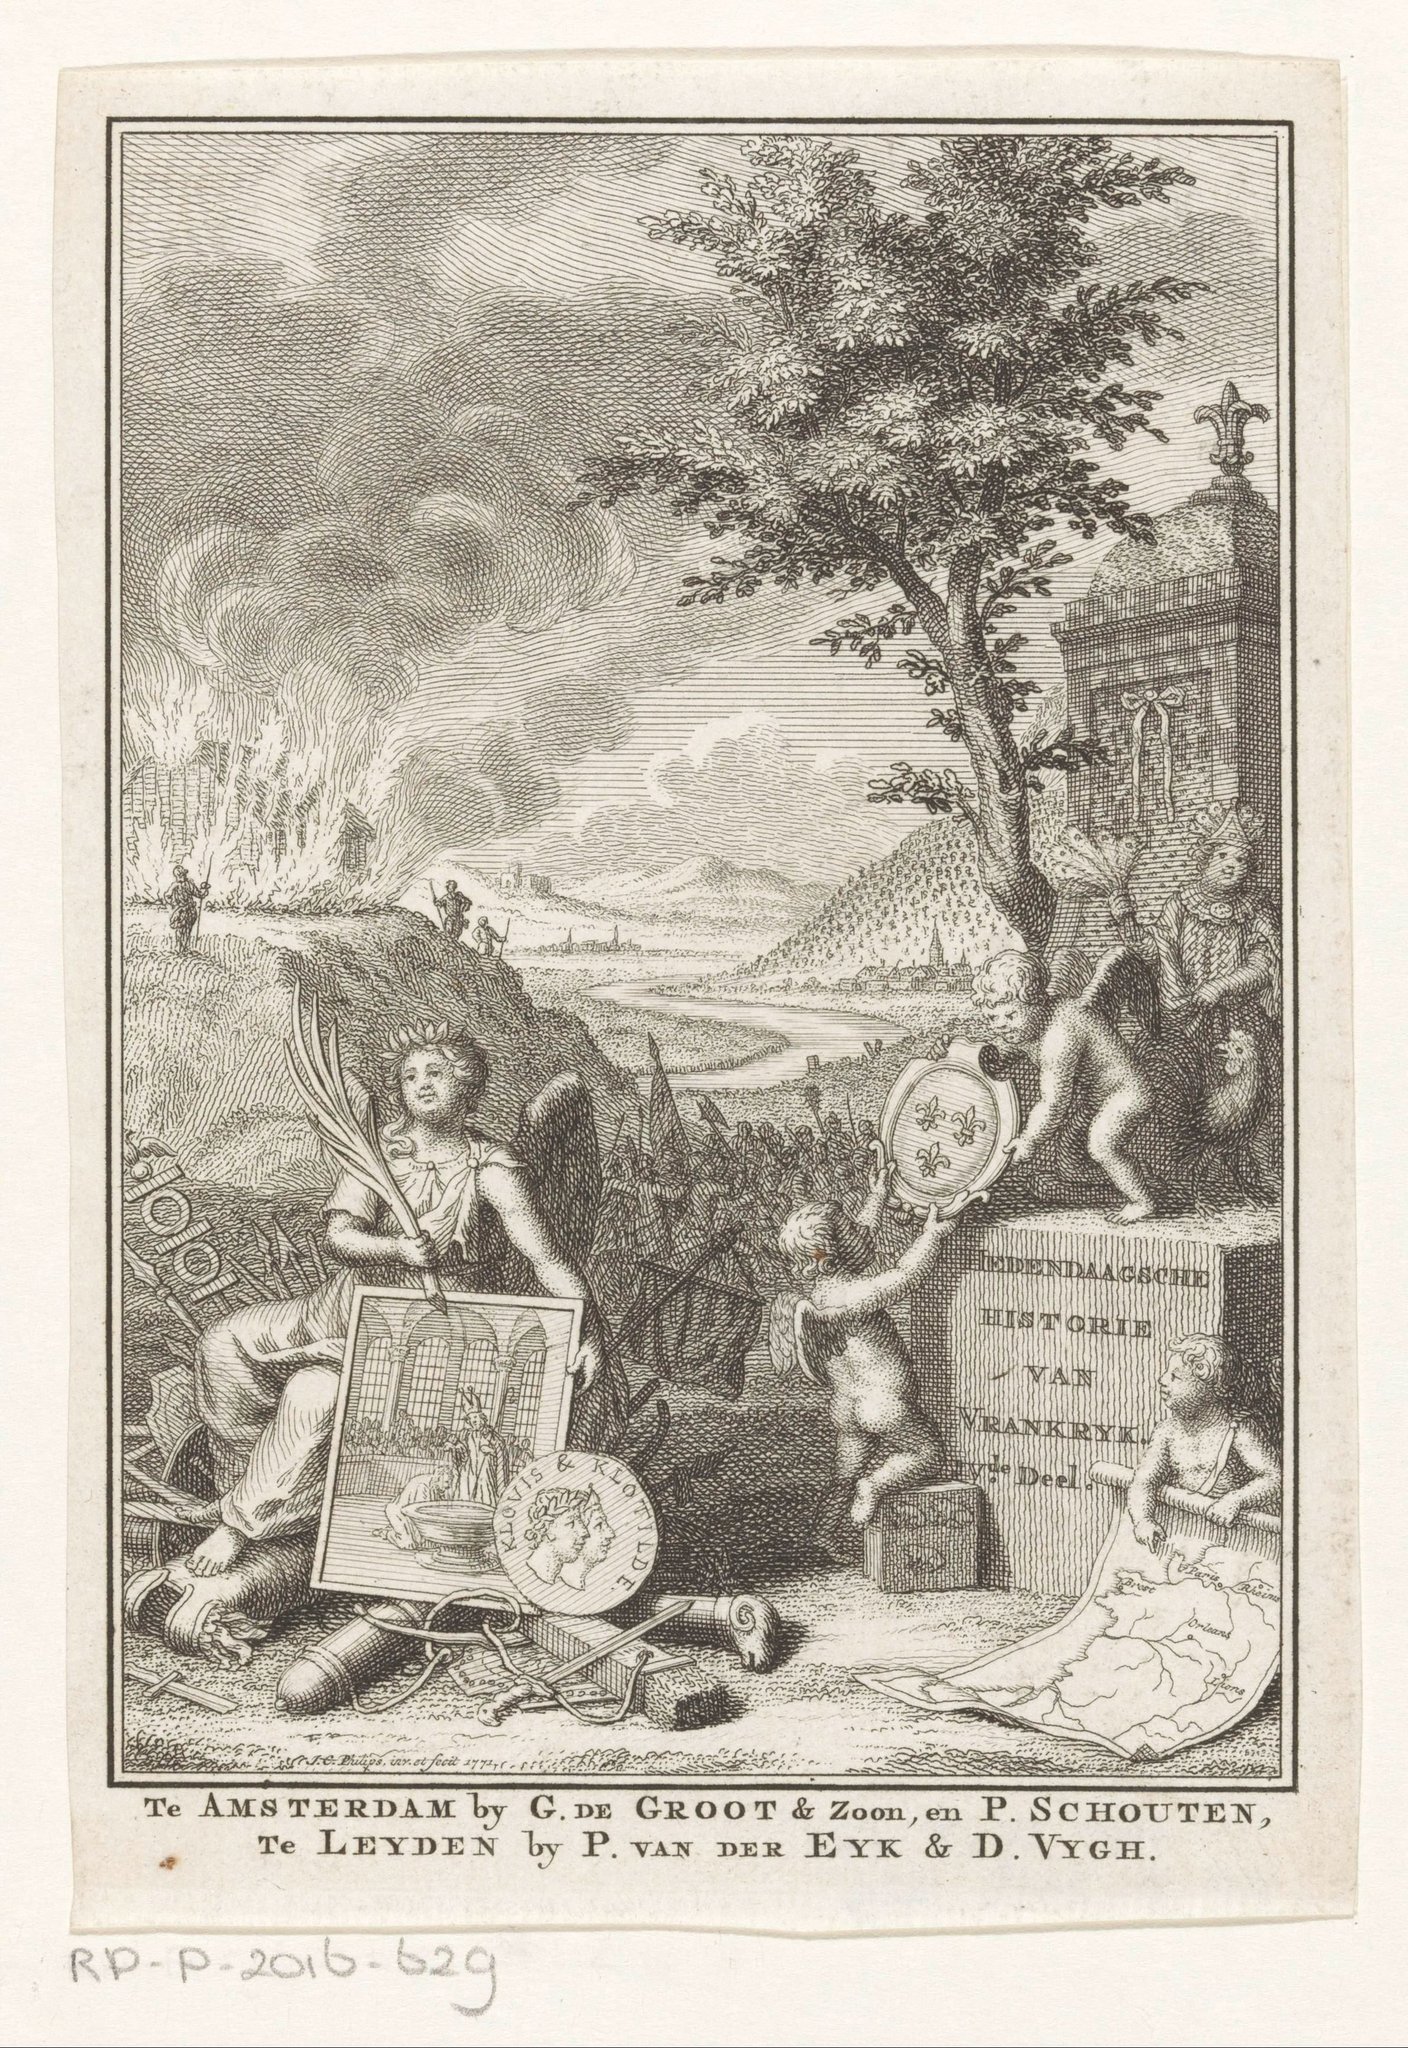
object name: print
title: Titelpagina voor: Thomas Salmon, Hedendaagsche historie of Het vervolg van de Algemeene historie, 1772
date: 1771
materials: paper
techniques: engraving, etching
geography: amsterdam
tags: personifications of countries, nations, states, districts, etc., 'historia'; 'historia' (ripa), france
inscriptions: collector's mark: Lugt 2228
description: Titelpagina voor: Salmon, Thomas. Hedendaagsche historie of Het vervolg van de Algemeene historie (...) IVde Deel. Amsterdam: Groot en Zoon, Gerrit de en Schouten, Petrus, Leiden: Eyk, Pieter van der en Vijgh, Daniel, 1772. Prent afkomstig uit een plakalbum met titelprenten, ornamenten etc. op blauw papier in 1983 uit elkaar gehaald. Volgens een notitie op verso zat de prent op p. 201 van dit album.